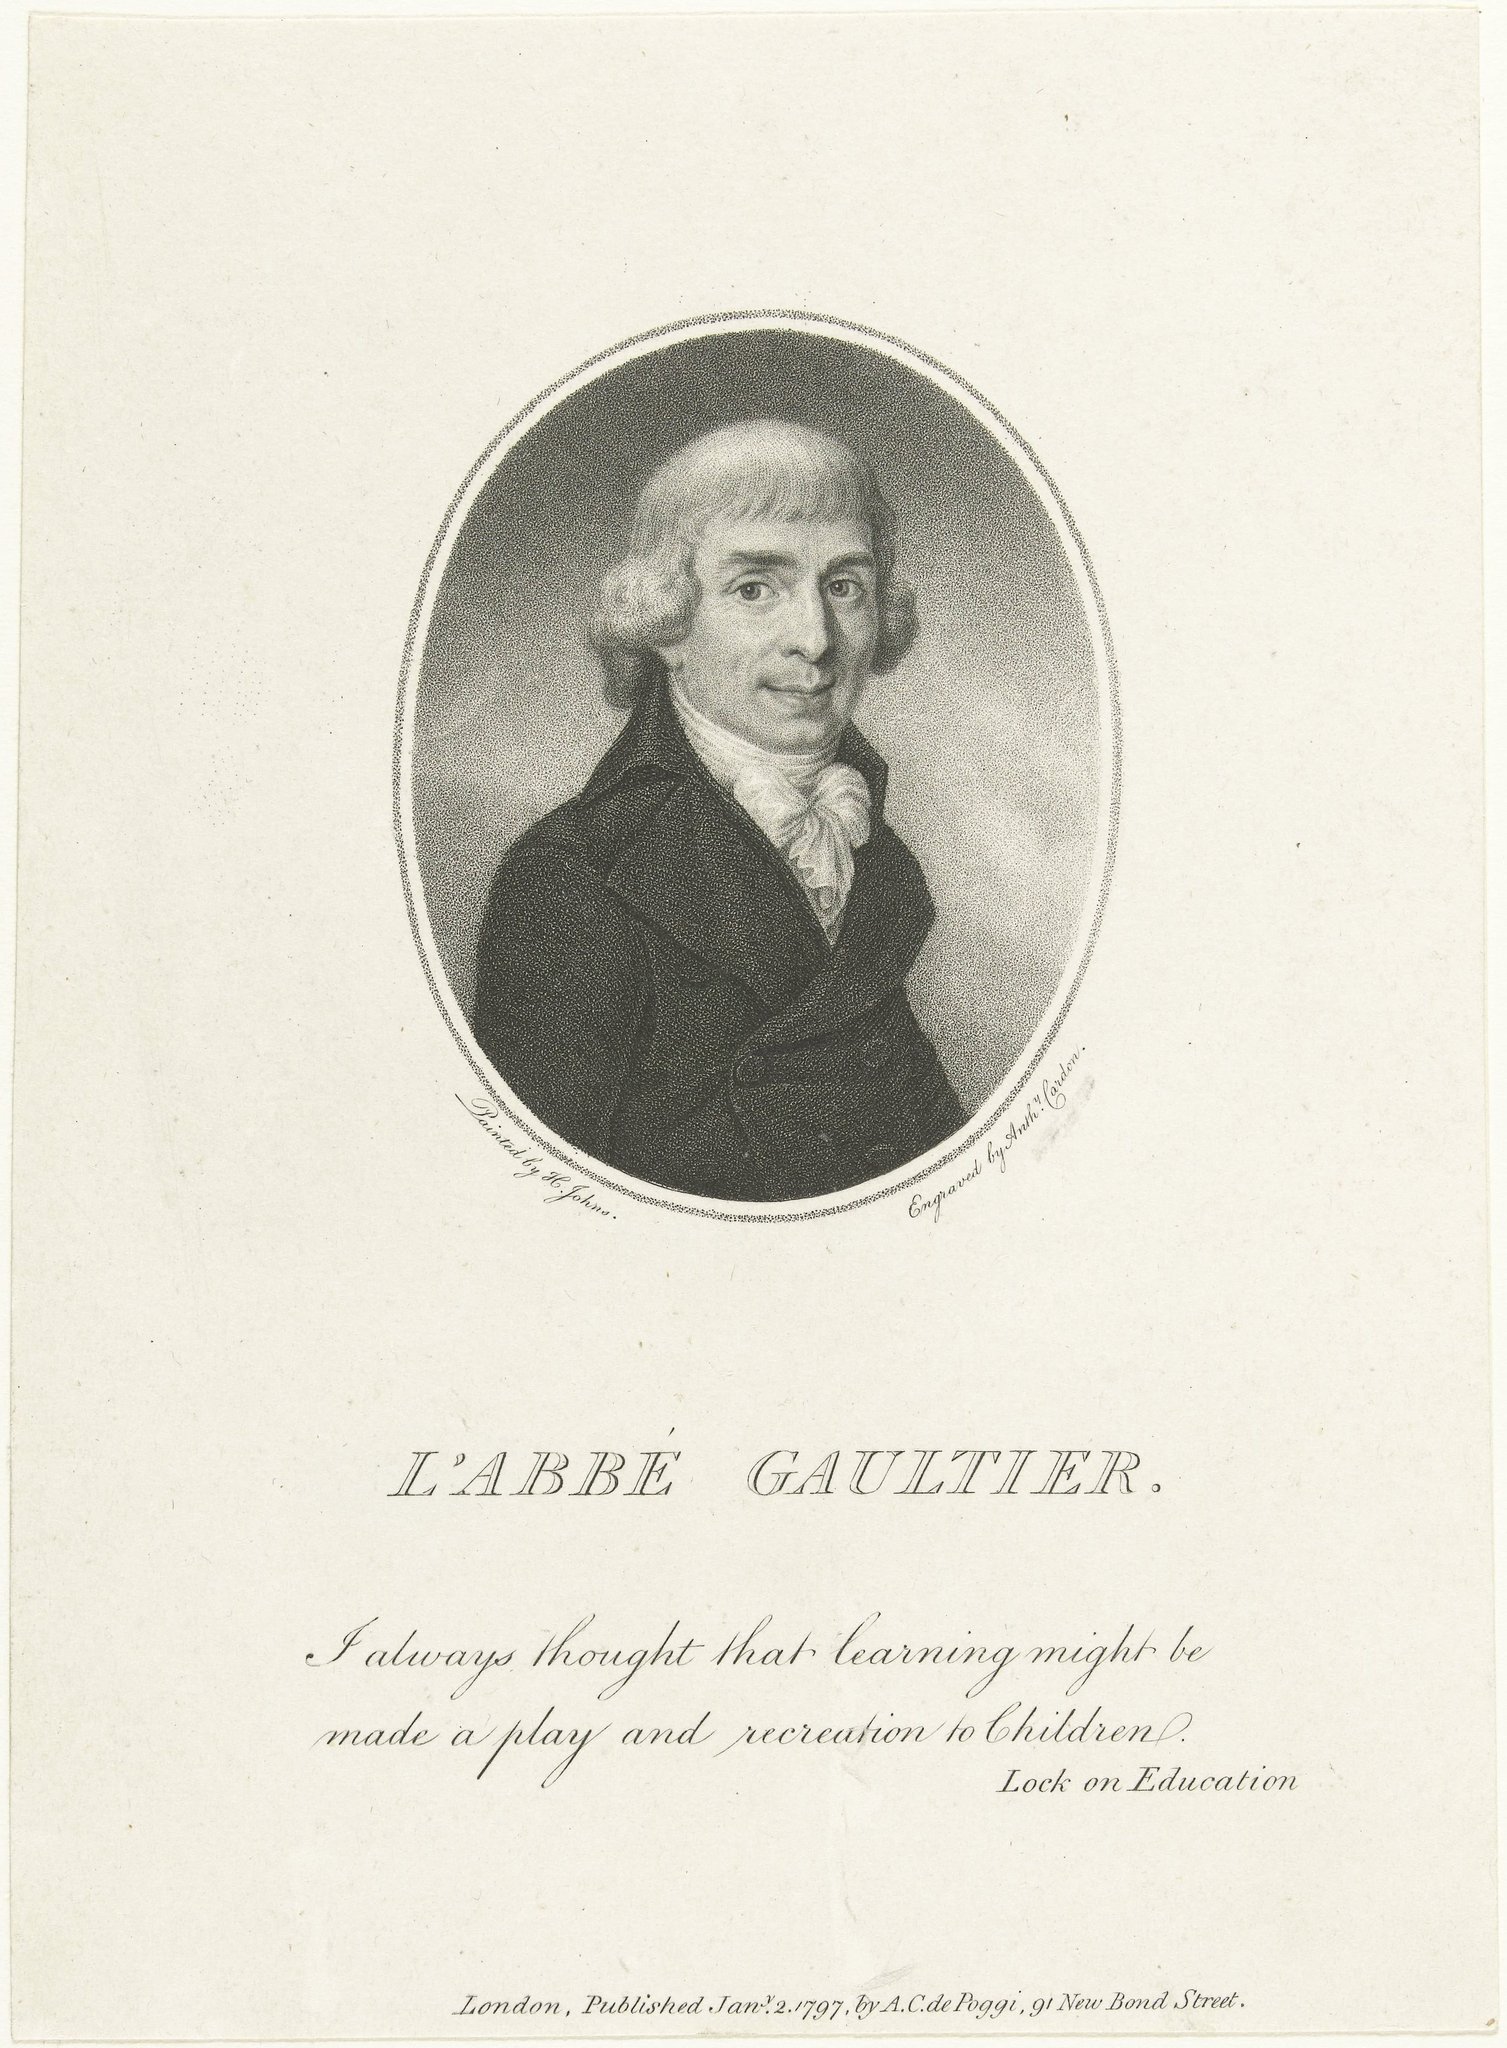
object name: print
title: Portret van Aloisius-Edouard-Camille Gaultier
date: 1797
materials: paper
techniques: etching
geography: london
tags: priest, education, science and learning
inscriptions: collector's mark: Lugt 2228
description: Onder het portret een citaat uit een werk van John Locke.